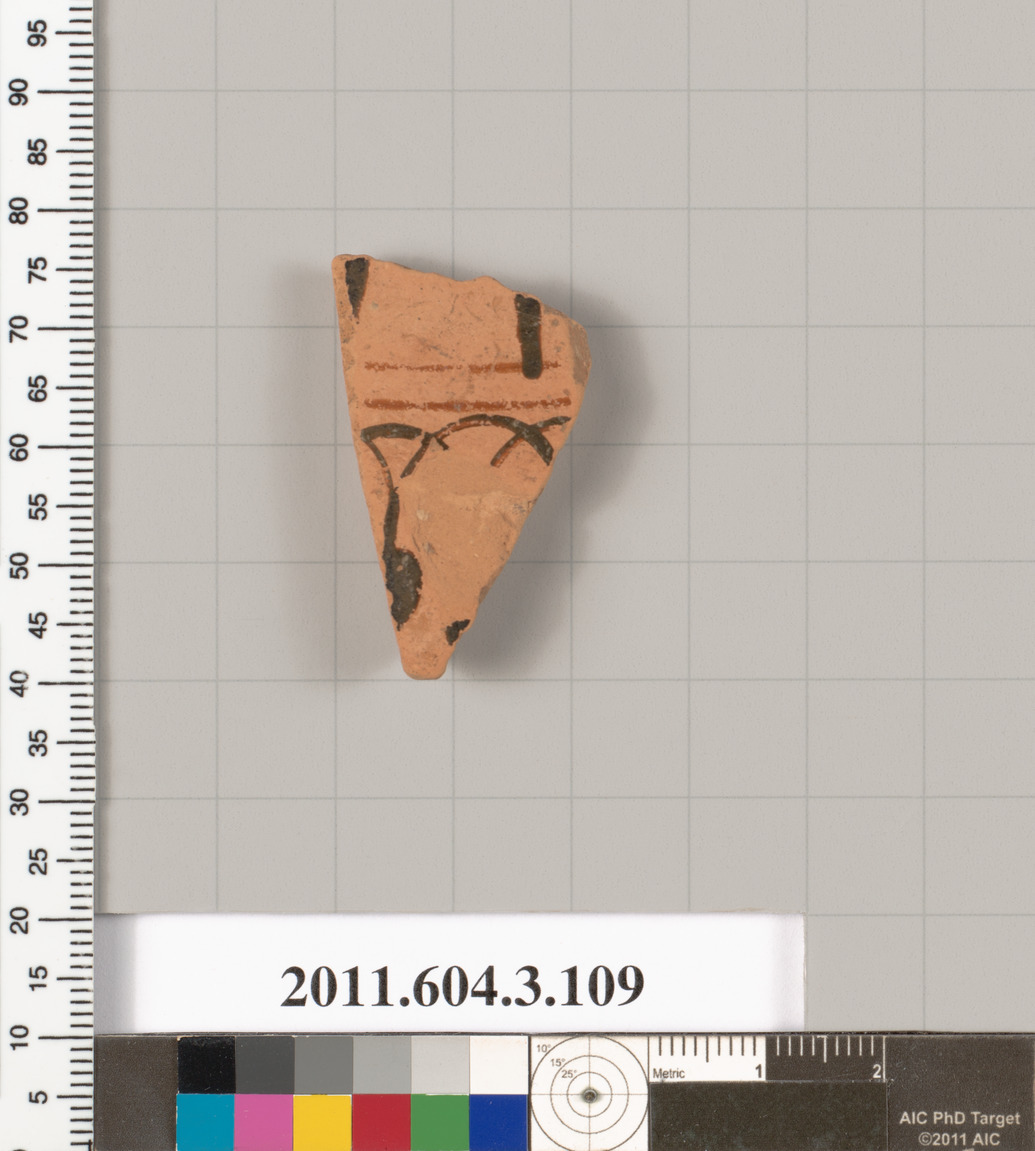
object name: amphora fragment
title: Terracotta fragment of an amphora (jar)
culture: greek, attic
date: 540 BCE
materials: terracotta